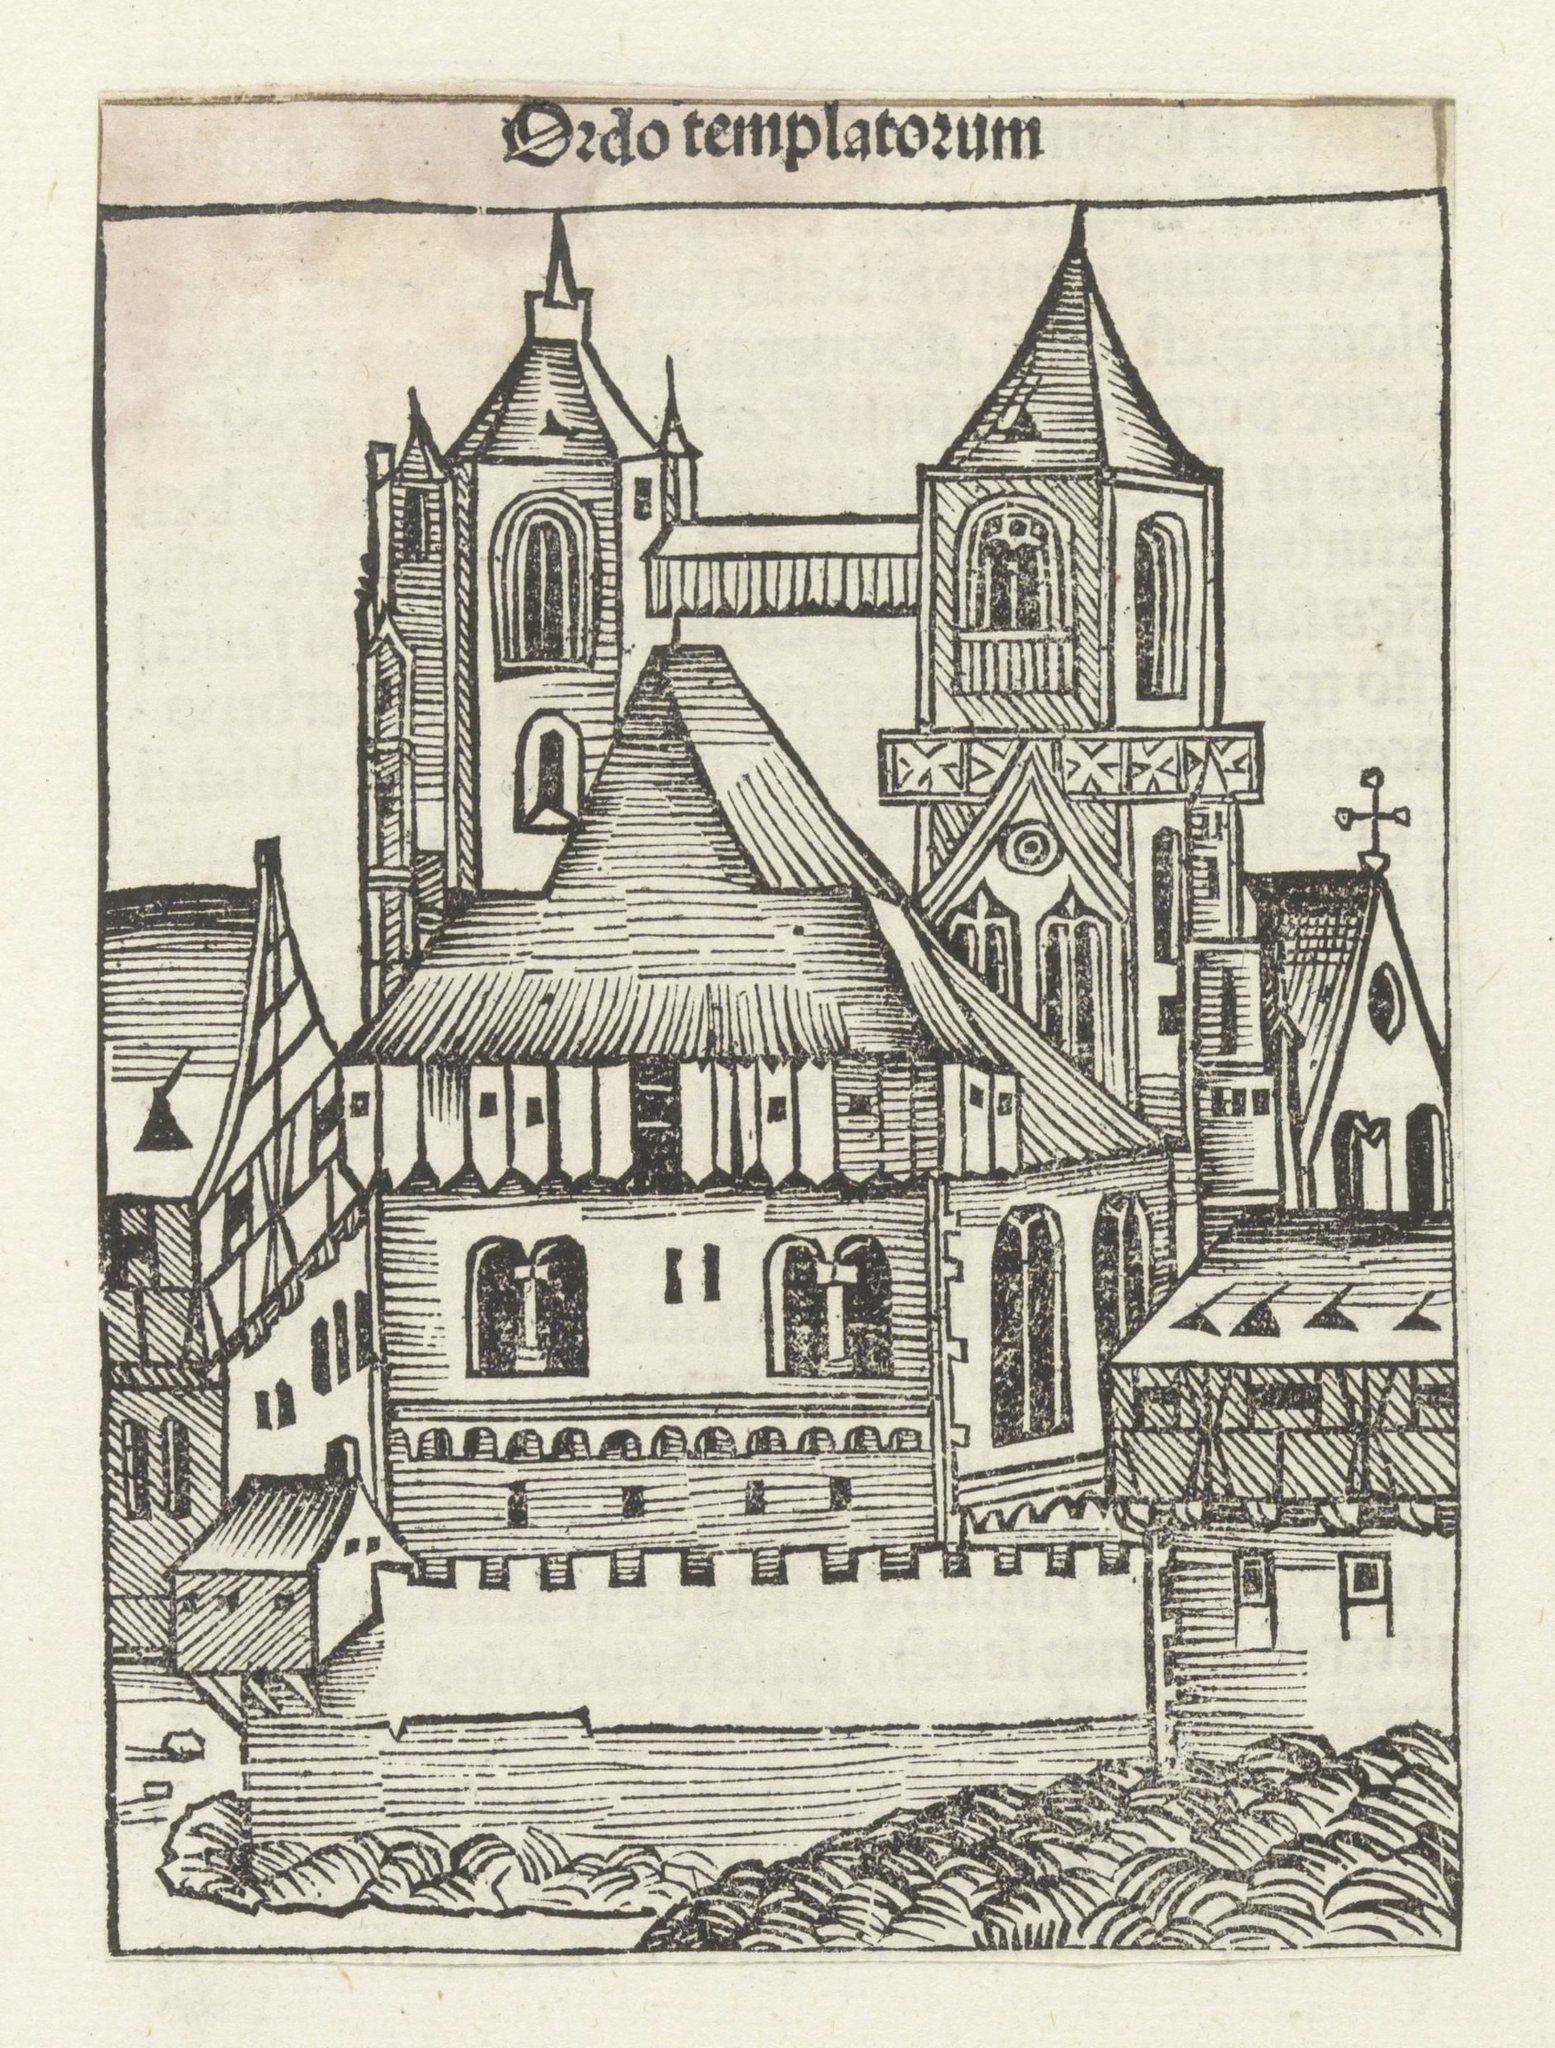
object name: album leaf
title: Ordo templatorum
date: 1493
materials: paper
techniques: letterpress printing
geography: nuremberg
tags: abbey, monastery, convent ~ roman catholic church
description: De houtsnede wordt herhaaldelijk gebruikt als boekillustratie in de Liber Chronicarum (of Neurenbergkroniek) van Hartmann Schedel, verschenen in het Latijn en Duits in 1493. Zie de Latijnse uitgave, folio 197v.